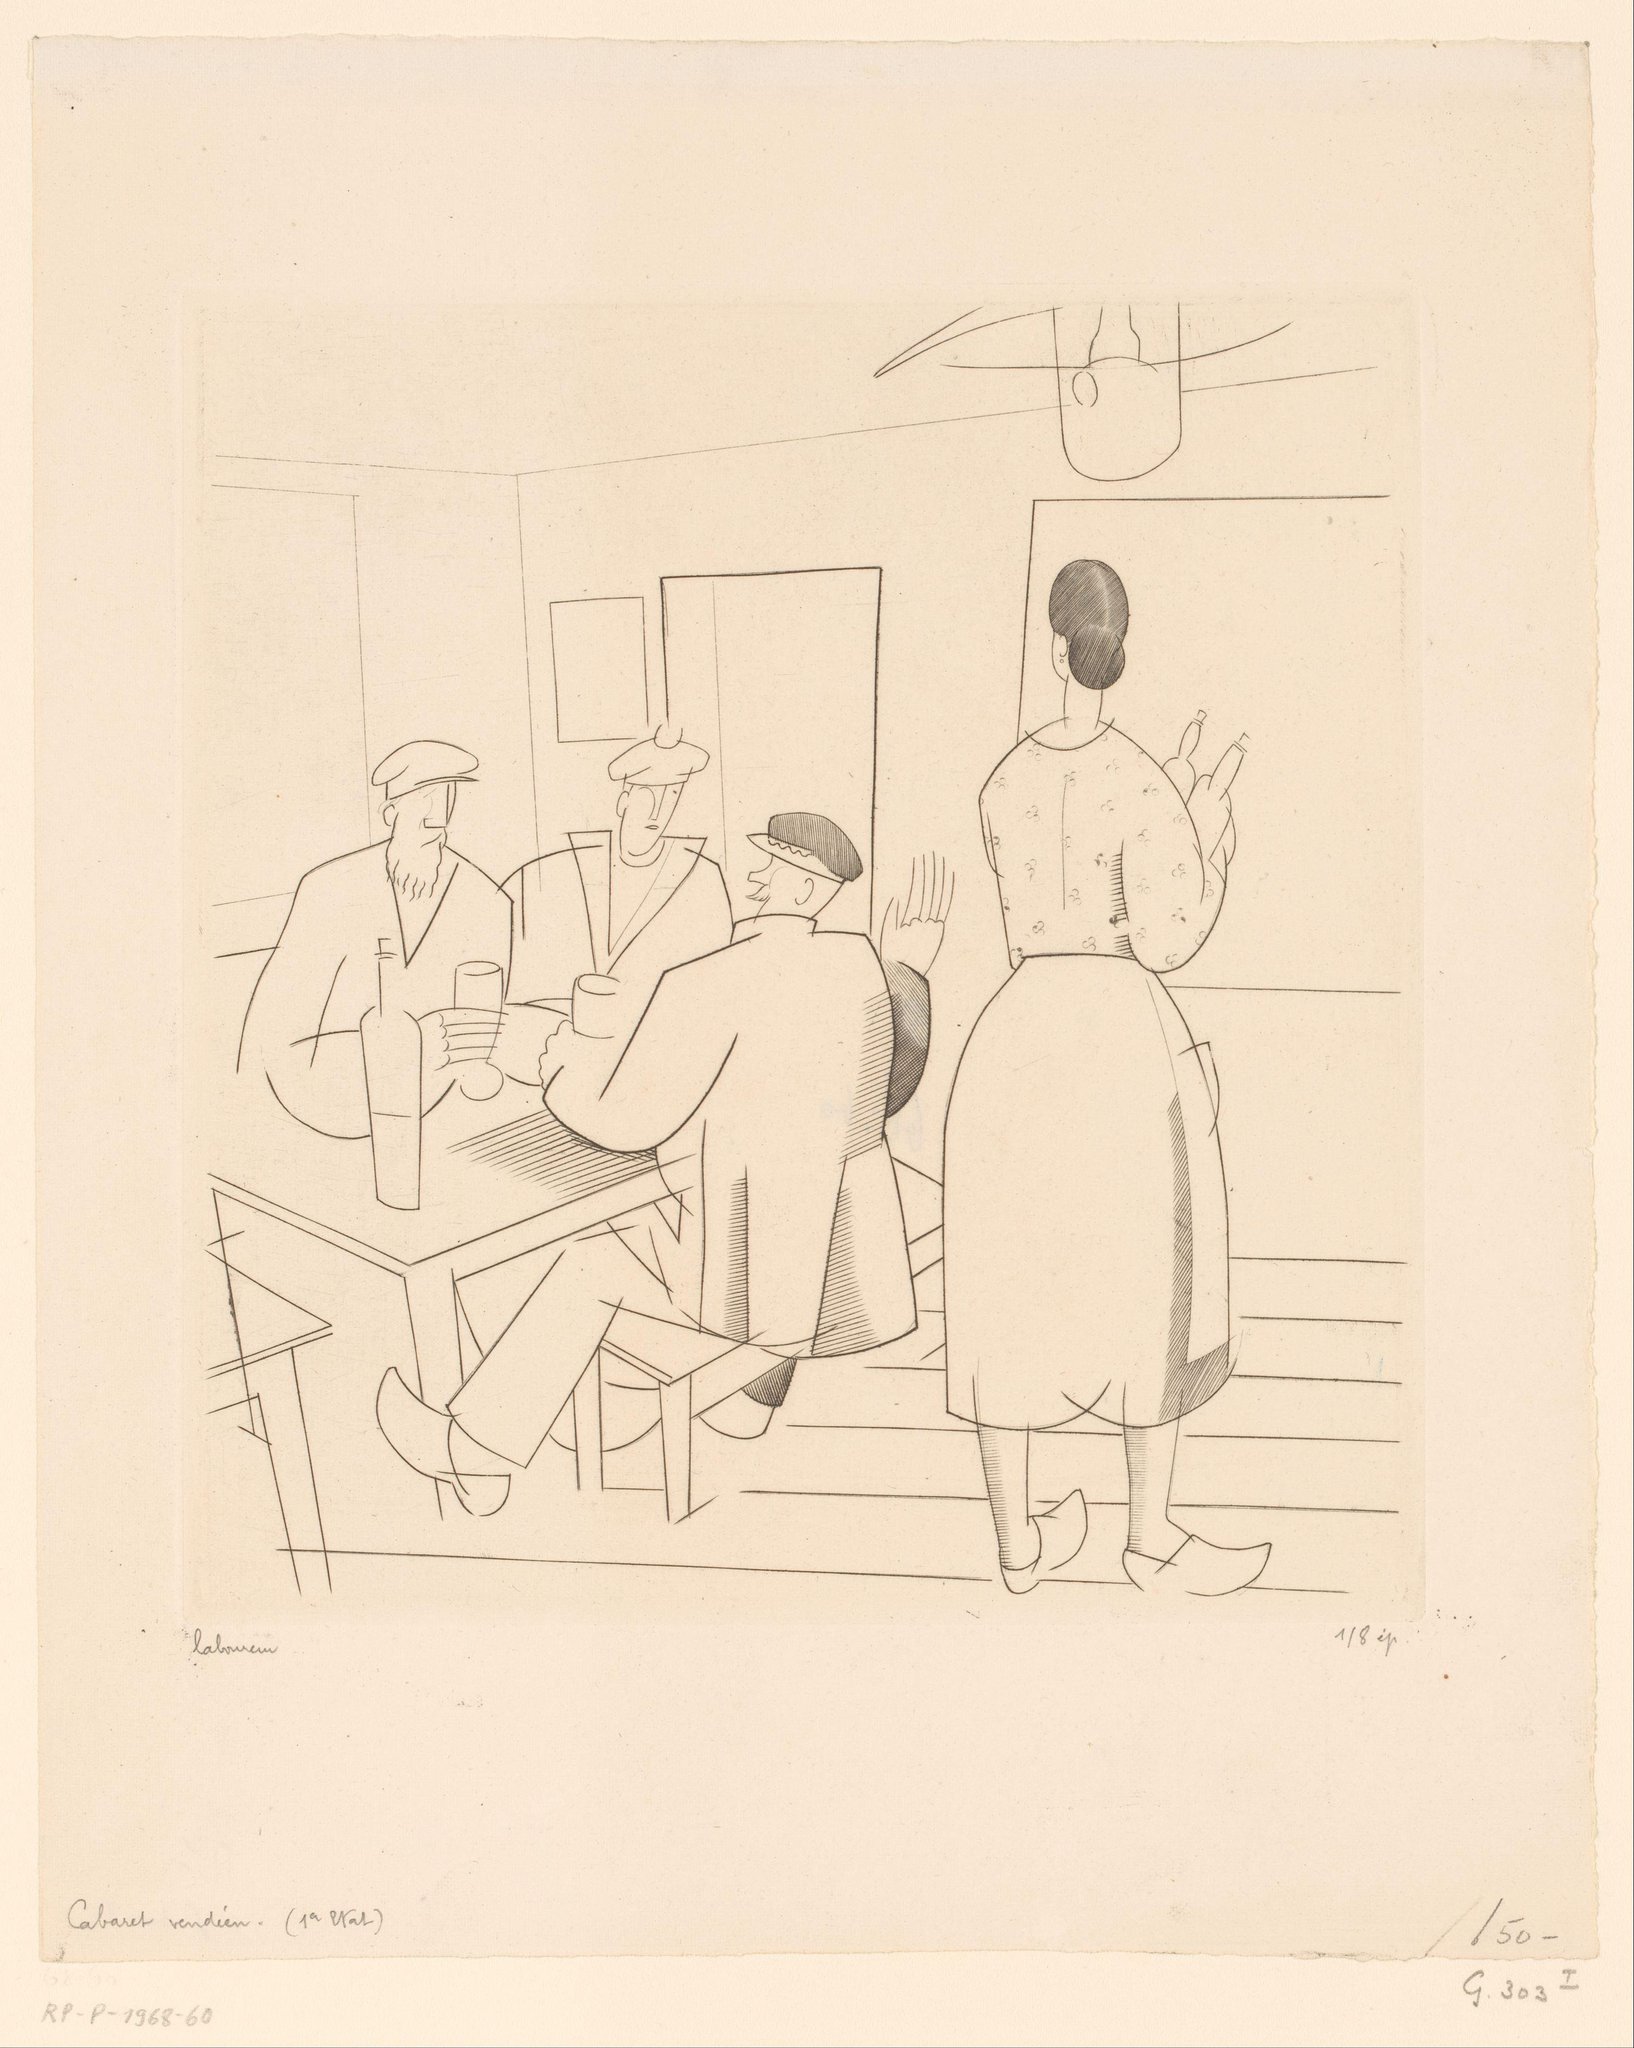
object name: print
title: Cabaret vendéen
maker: jean emile laboureur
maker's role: draughtsman, print maker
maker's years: 1877-1943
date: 1925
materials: paper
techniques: engraving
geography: france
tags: hotel, hostelry, inn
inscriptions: collector's mark: Lugt 2760, collector's mark: Lugt 2228